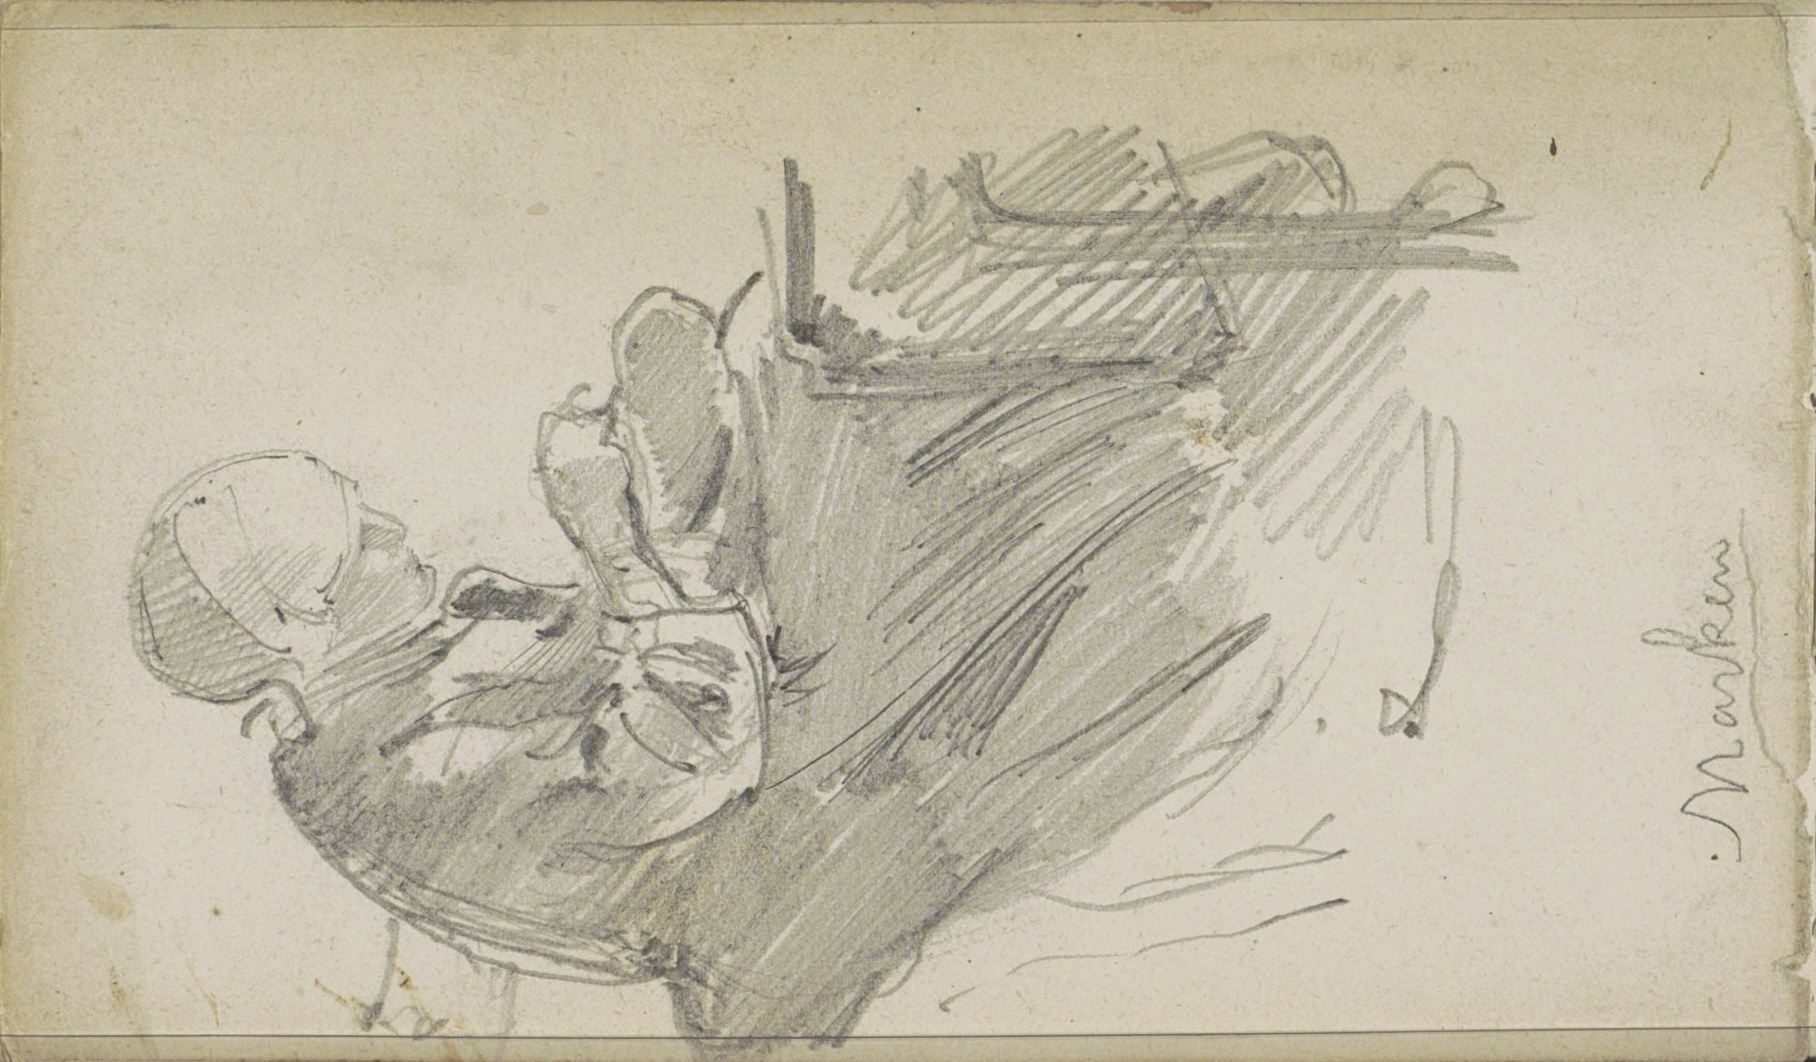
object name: sketchbook leaf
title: Handwerkende Marker vrouw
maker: george clausen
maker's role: draughtsman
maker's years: 1852-1912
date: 1875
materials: paper, pencil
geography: marken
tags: sitting figure, adult woman, folk costume, regional costume, home sewing; repair of clothes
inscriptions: annotation: ‘Marken’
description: Blad 13 verso uit een schetsboek met 46 bladen.